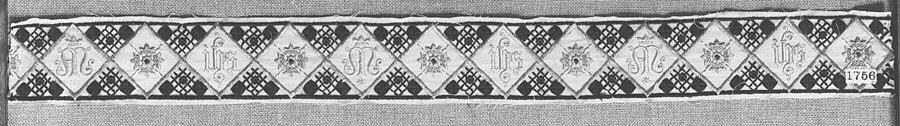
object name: band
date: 1801-1900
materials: cotton, silk